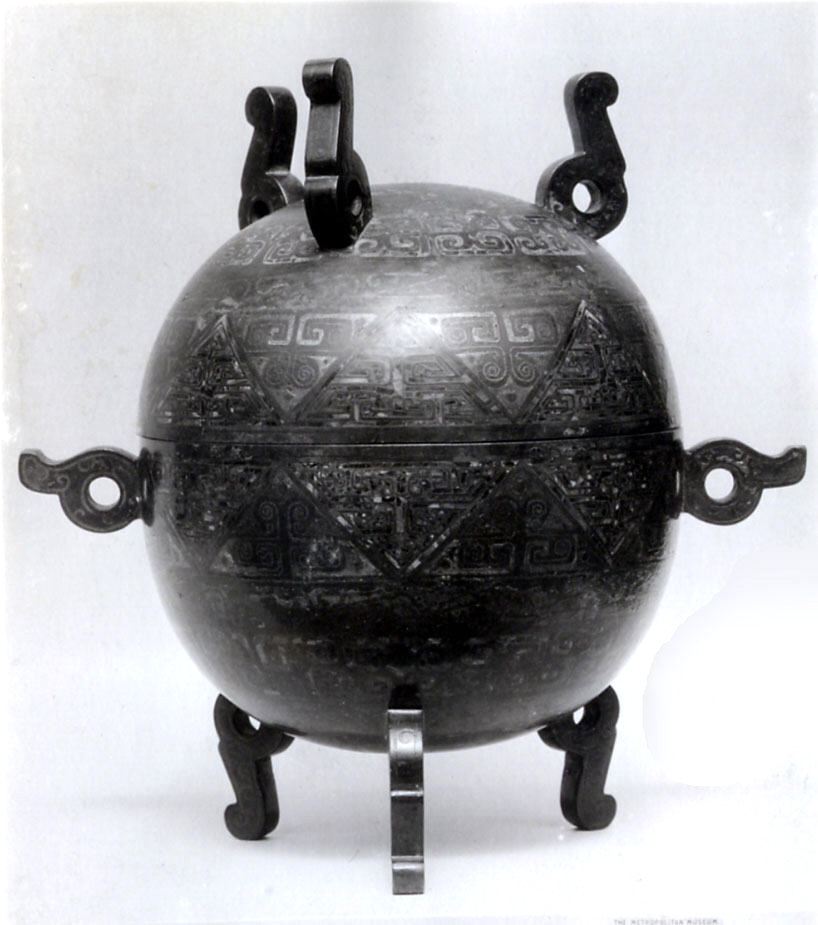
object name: covered tripod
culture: chinese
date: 1368-1644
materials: bronze, copper, silver